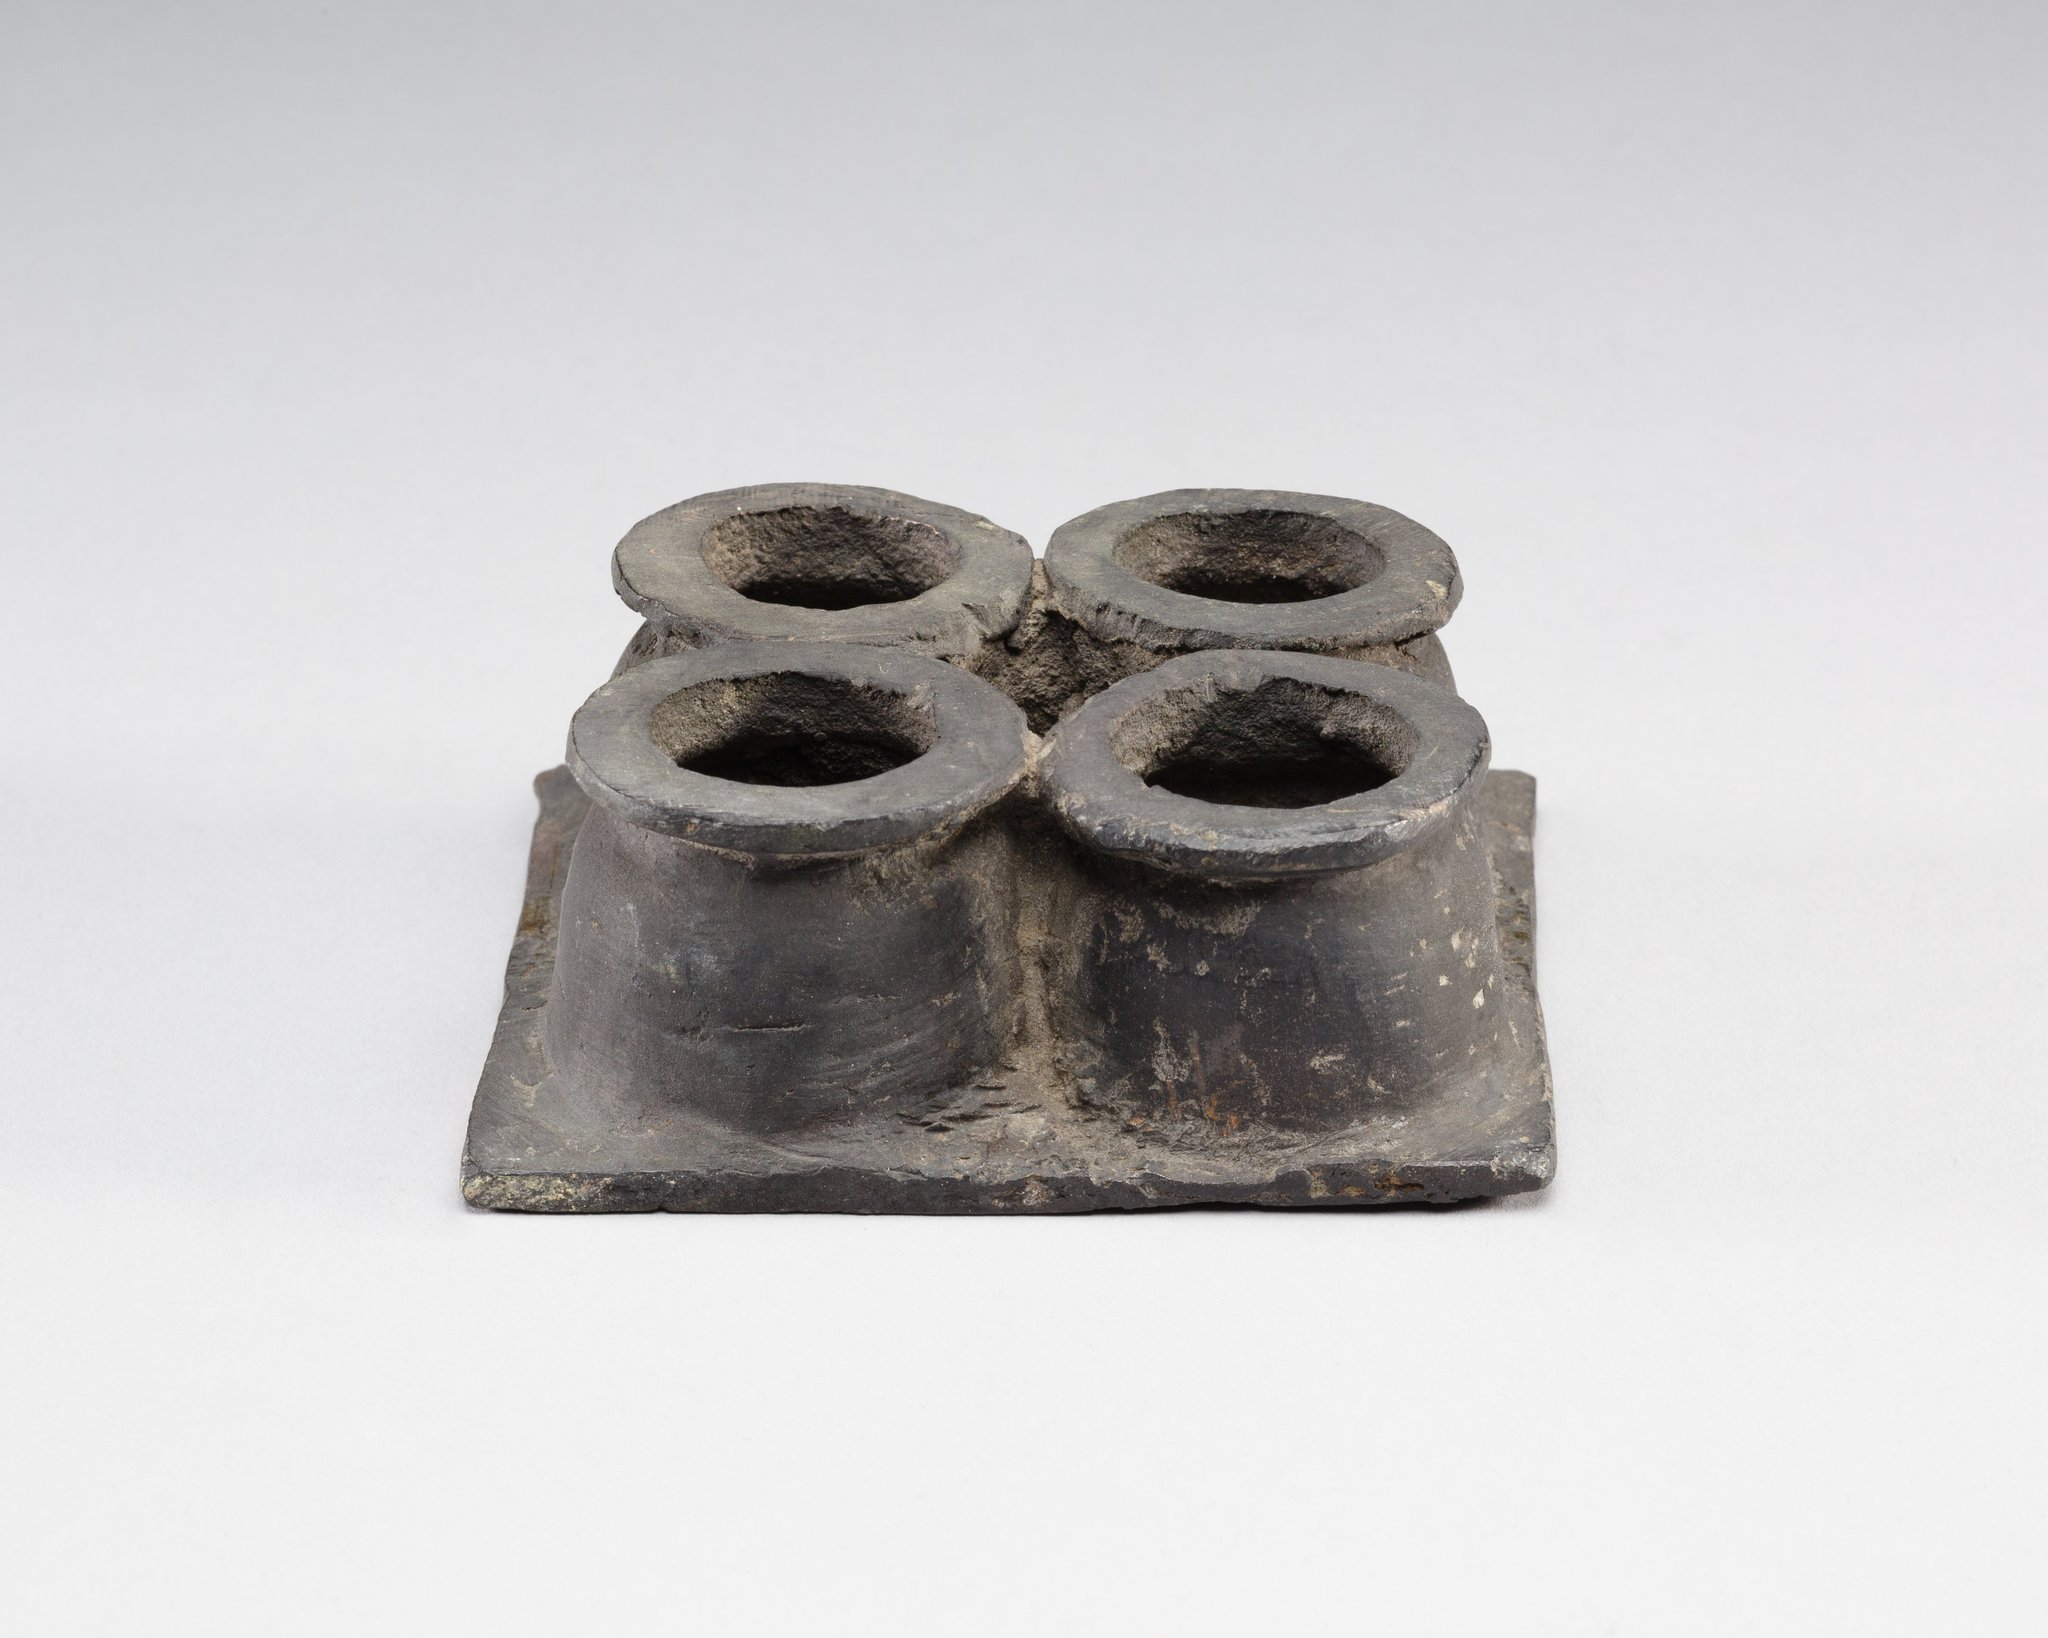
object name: pot, quadruple, nespekashuty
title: Integrated vessel model with four jars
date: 664-610 BCE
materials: lead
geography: egypt